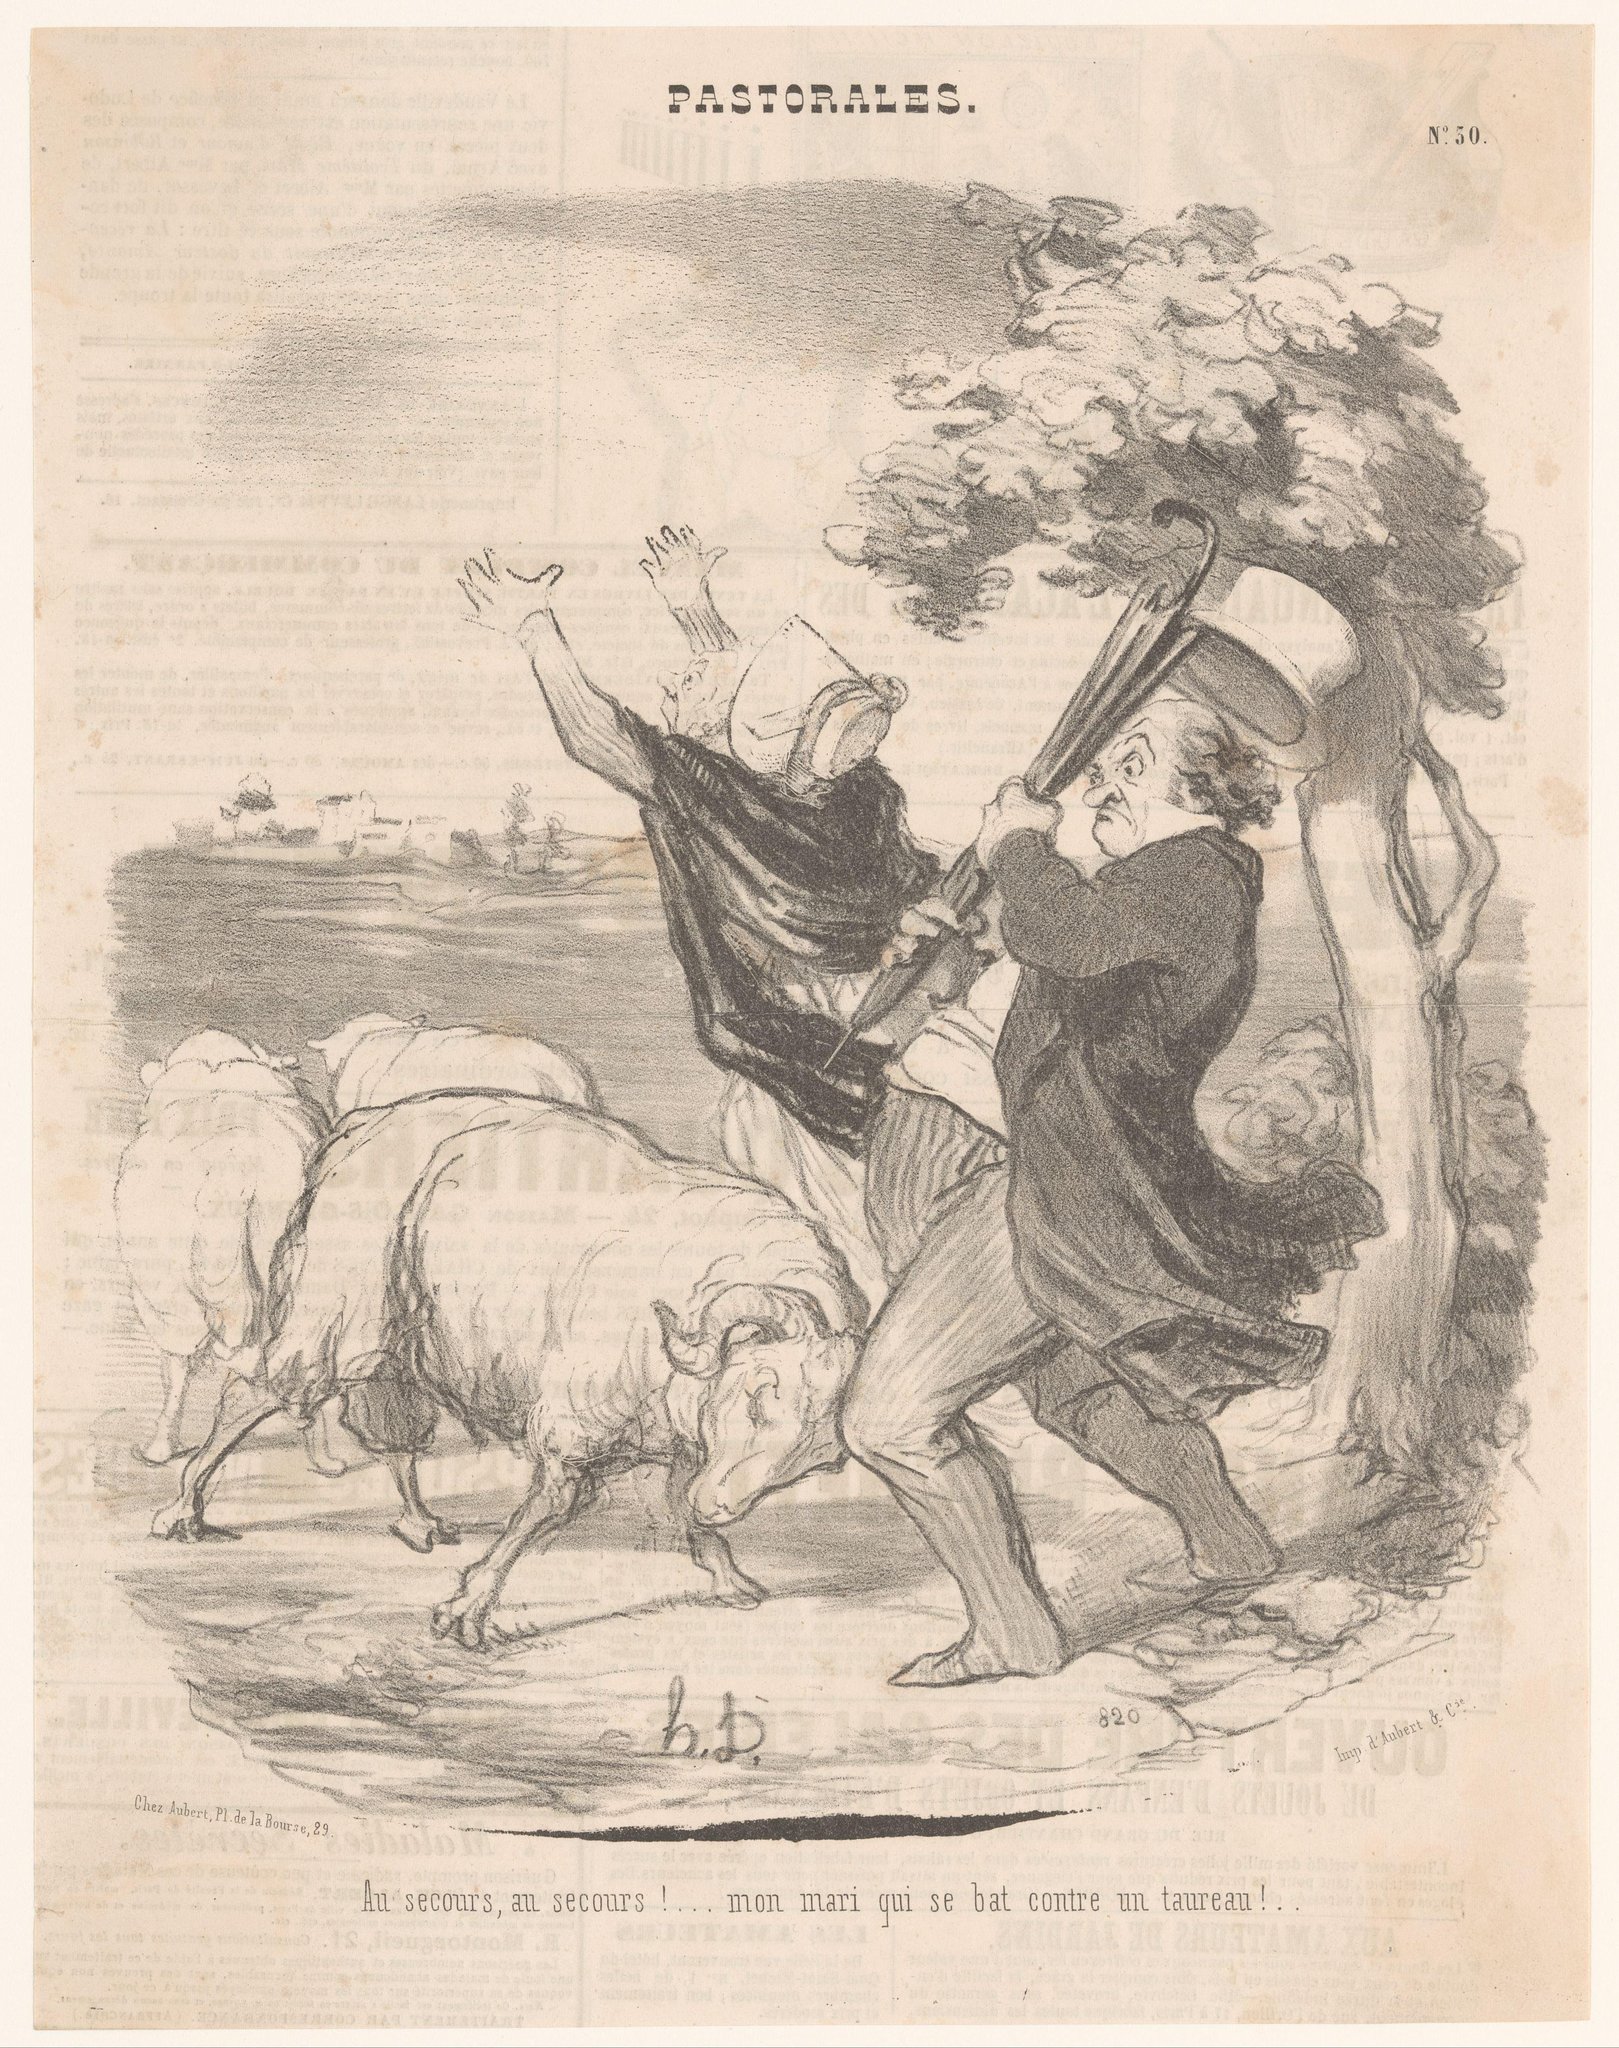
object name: cartoon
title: Au secours, au secours!.. Mon mari qui se bat contre un taureau!..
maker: honoré daumier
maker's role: draughtsman, painter, print maker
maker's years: 1808-1879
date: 1845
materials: paper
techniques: lithograph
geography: paris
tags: caricatures (human types), ram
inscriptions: collector's mark: Lugt 2228a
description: Prent gebruikt voor: Le Charivari, 14-12-1845.